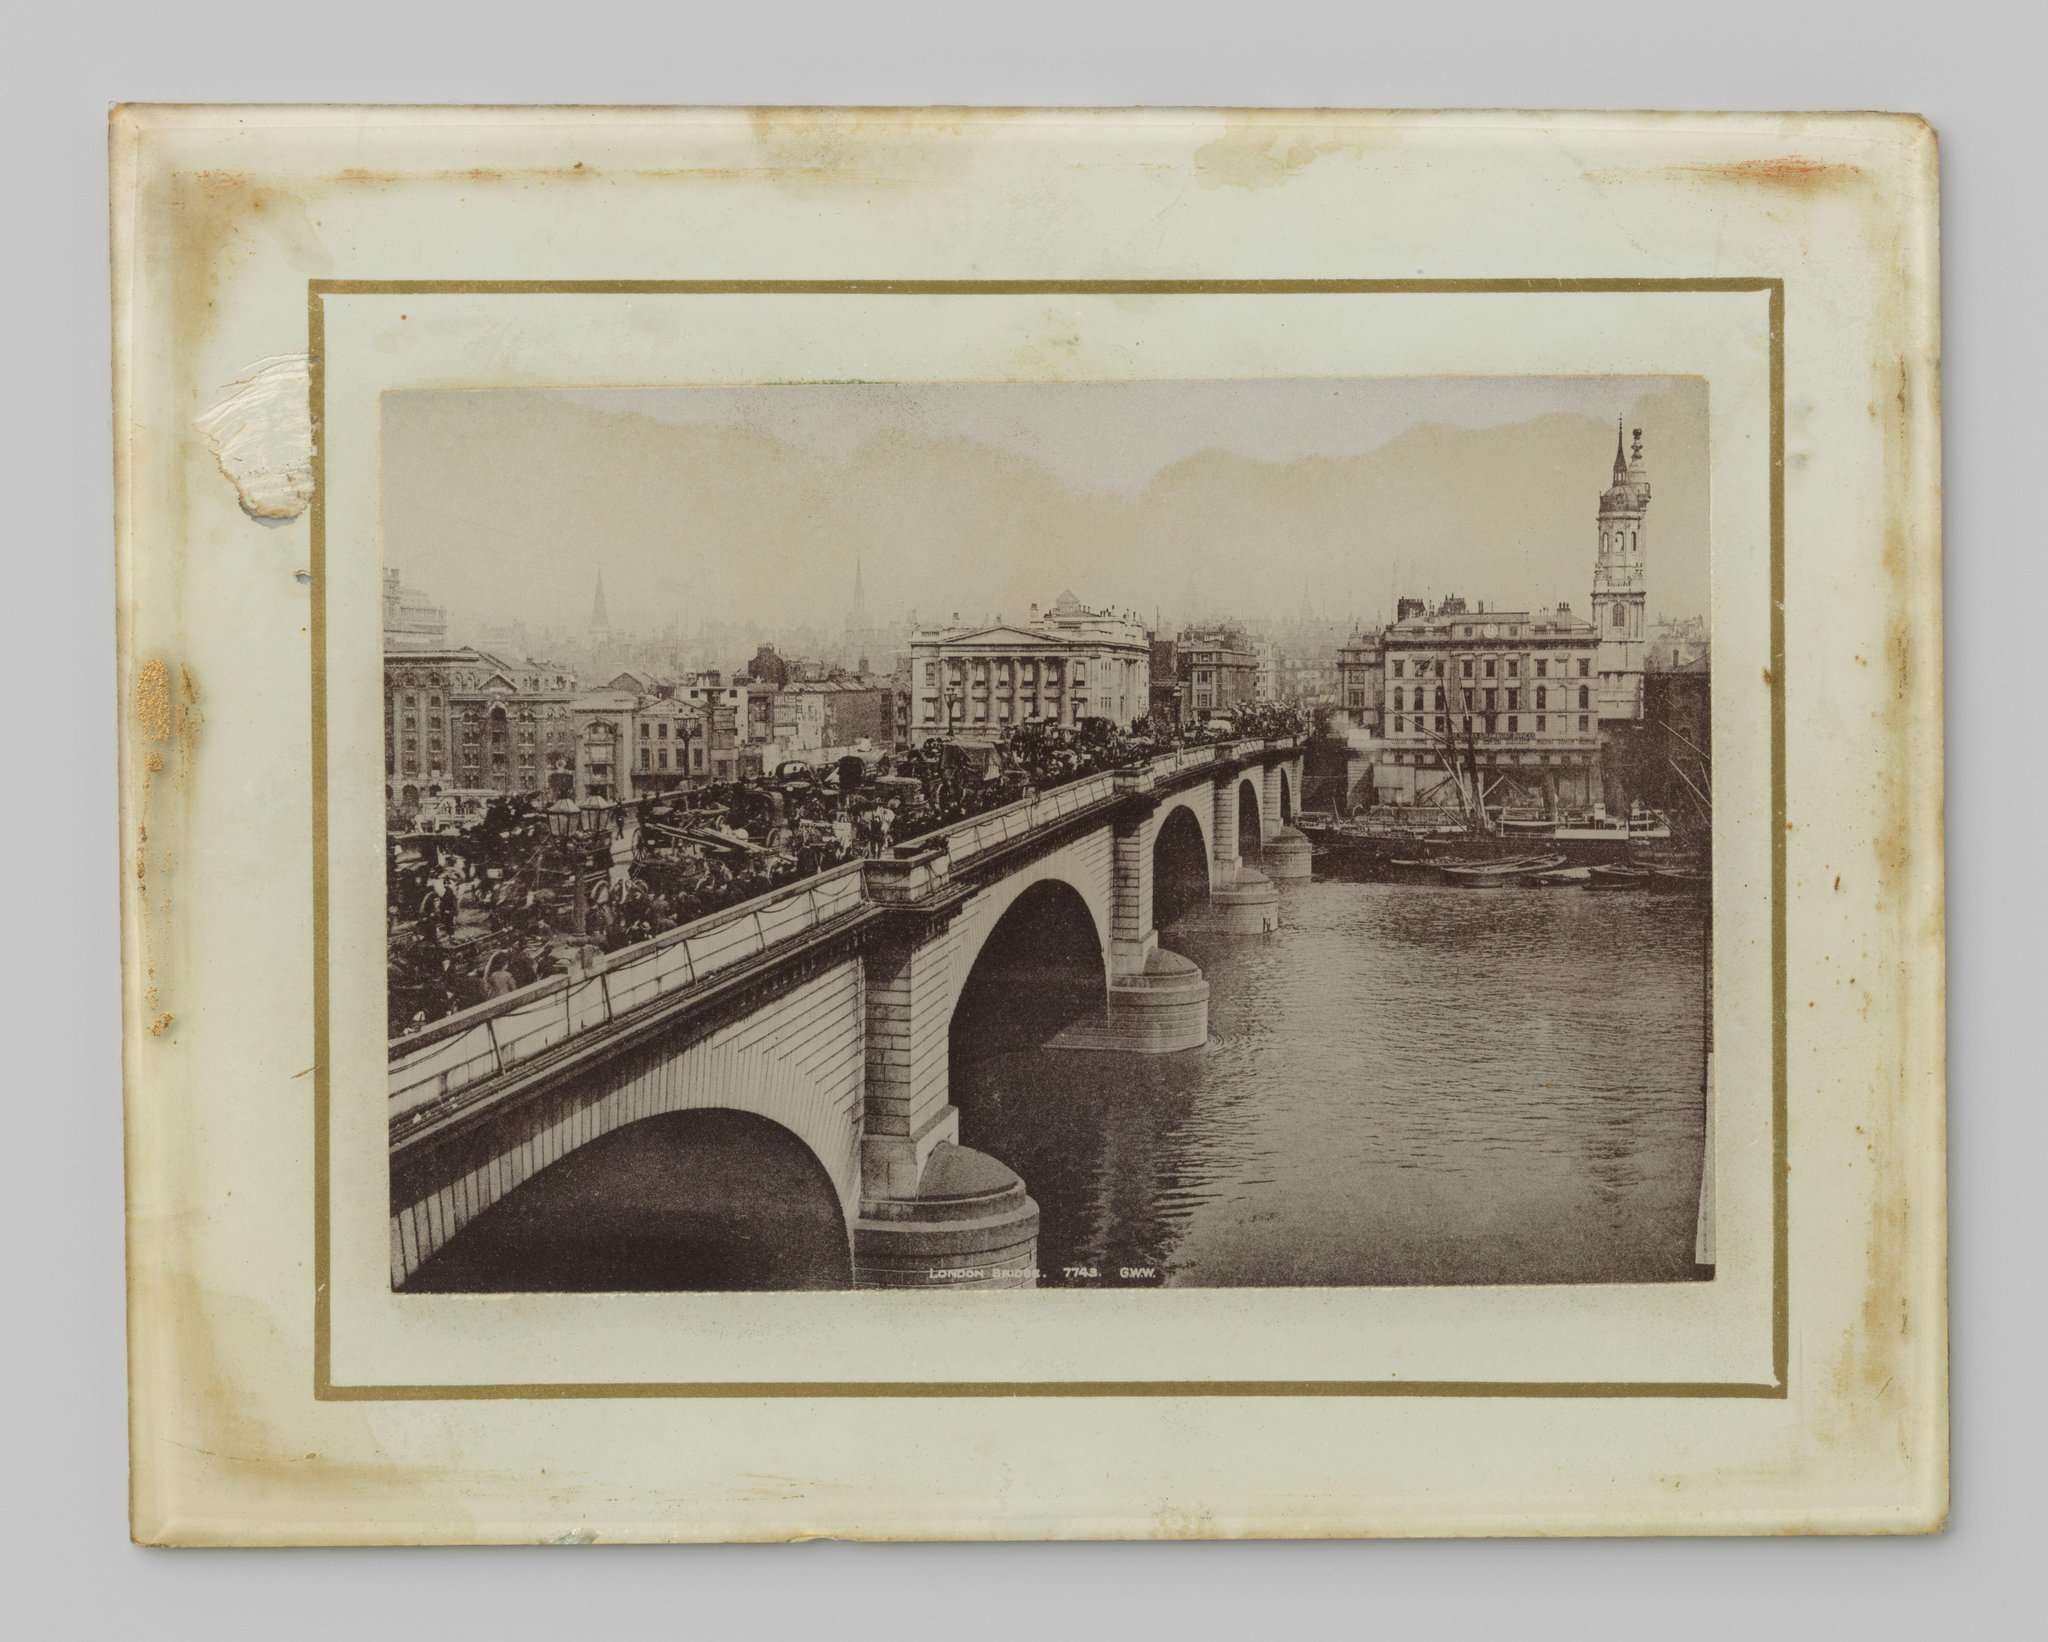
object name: photomechanical print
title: Gezicht op de London Bridge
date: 1880-1900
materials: glass, paper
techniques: photograph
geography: london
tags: bridge in city across river, canal, etc.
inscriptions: number: ‘7743.’